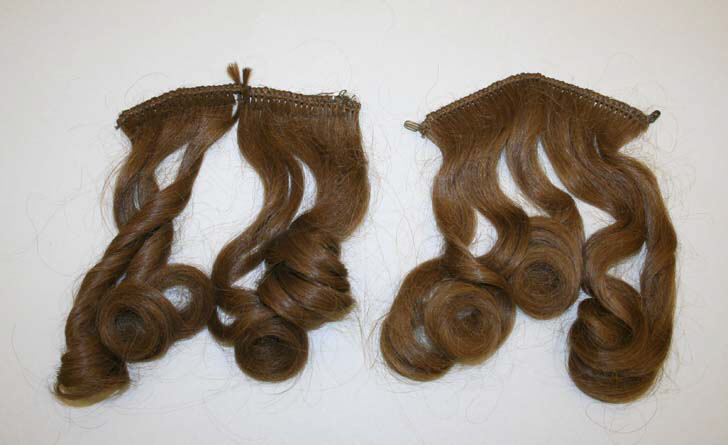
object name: accessory set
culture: american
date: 1801-1900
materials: hair